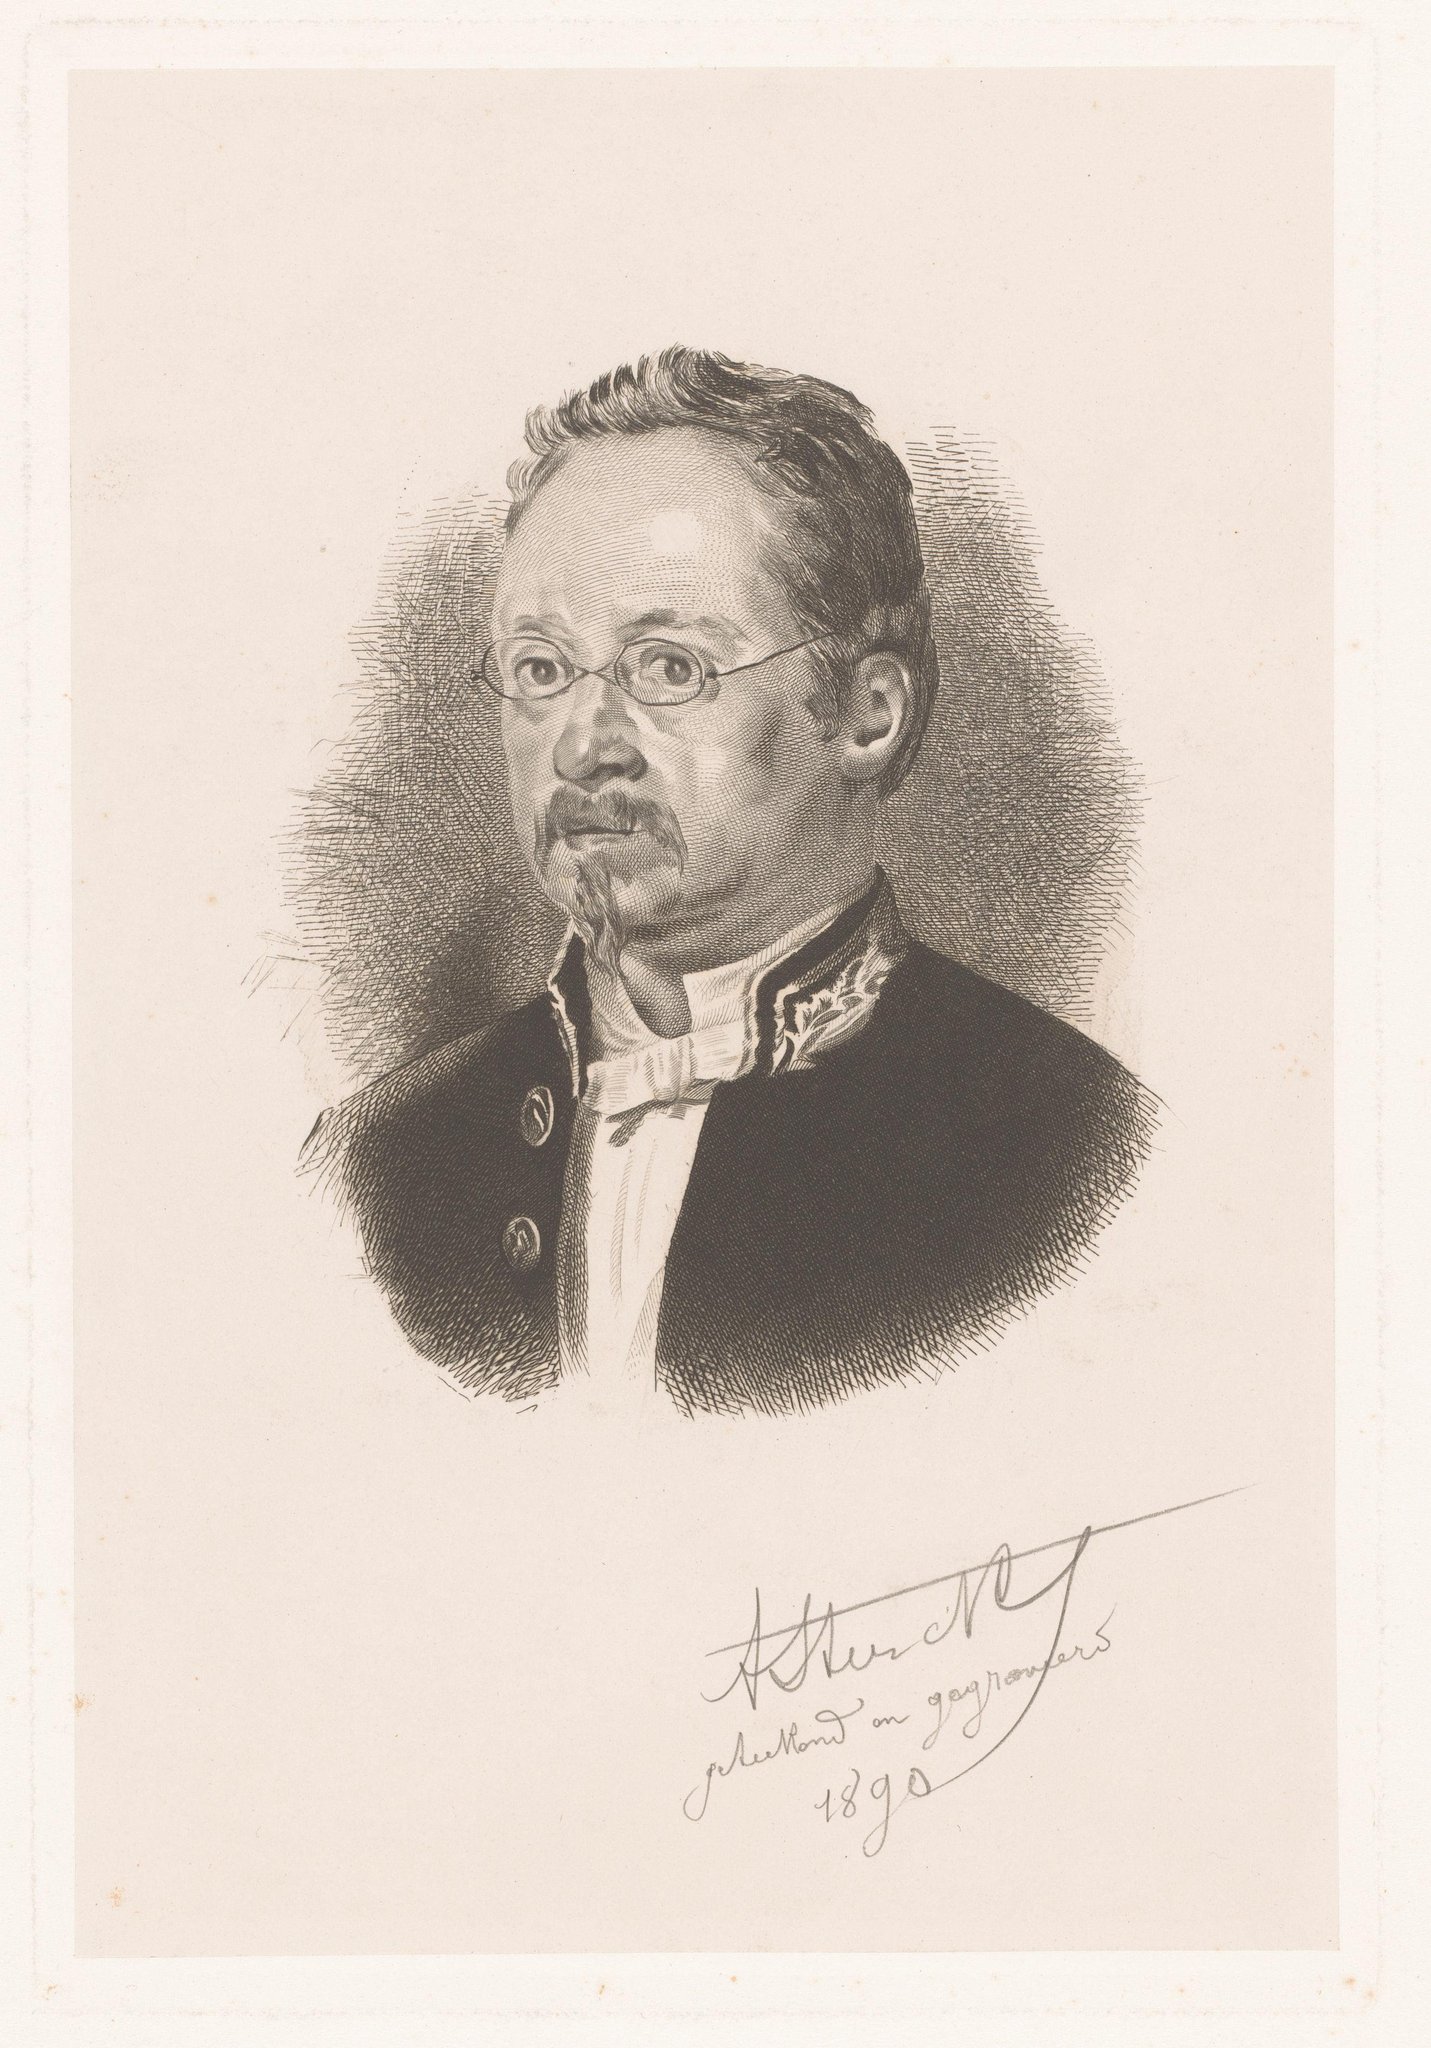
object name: print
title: Portret van Emile Allewaert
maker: arthur sterck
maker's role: print maker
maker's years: 1868-1897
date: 1890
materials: paper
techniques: drypoint, etching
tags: politician, historical persons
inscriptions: collector's mark: Lugt 2228